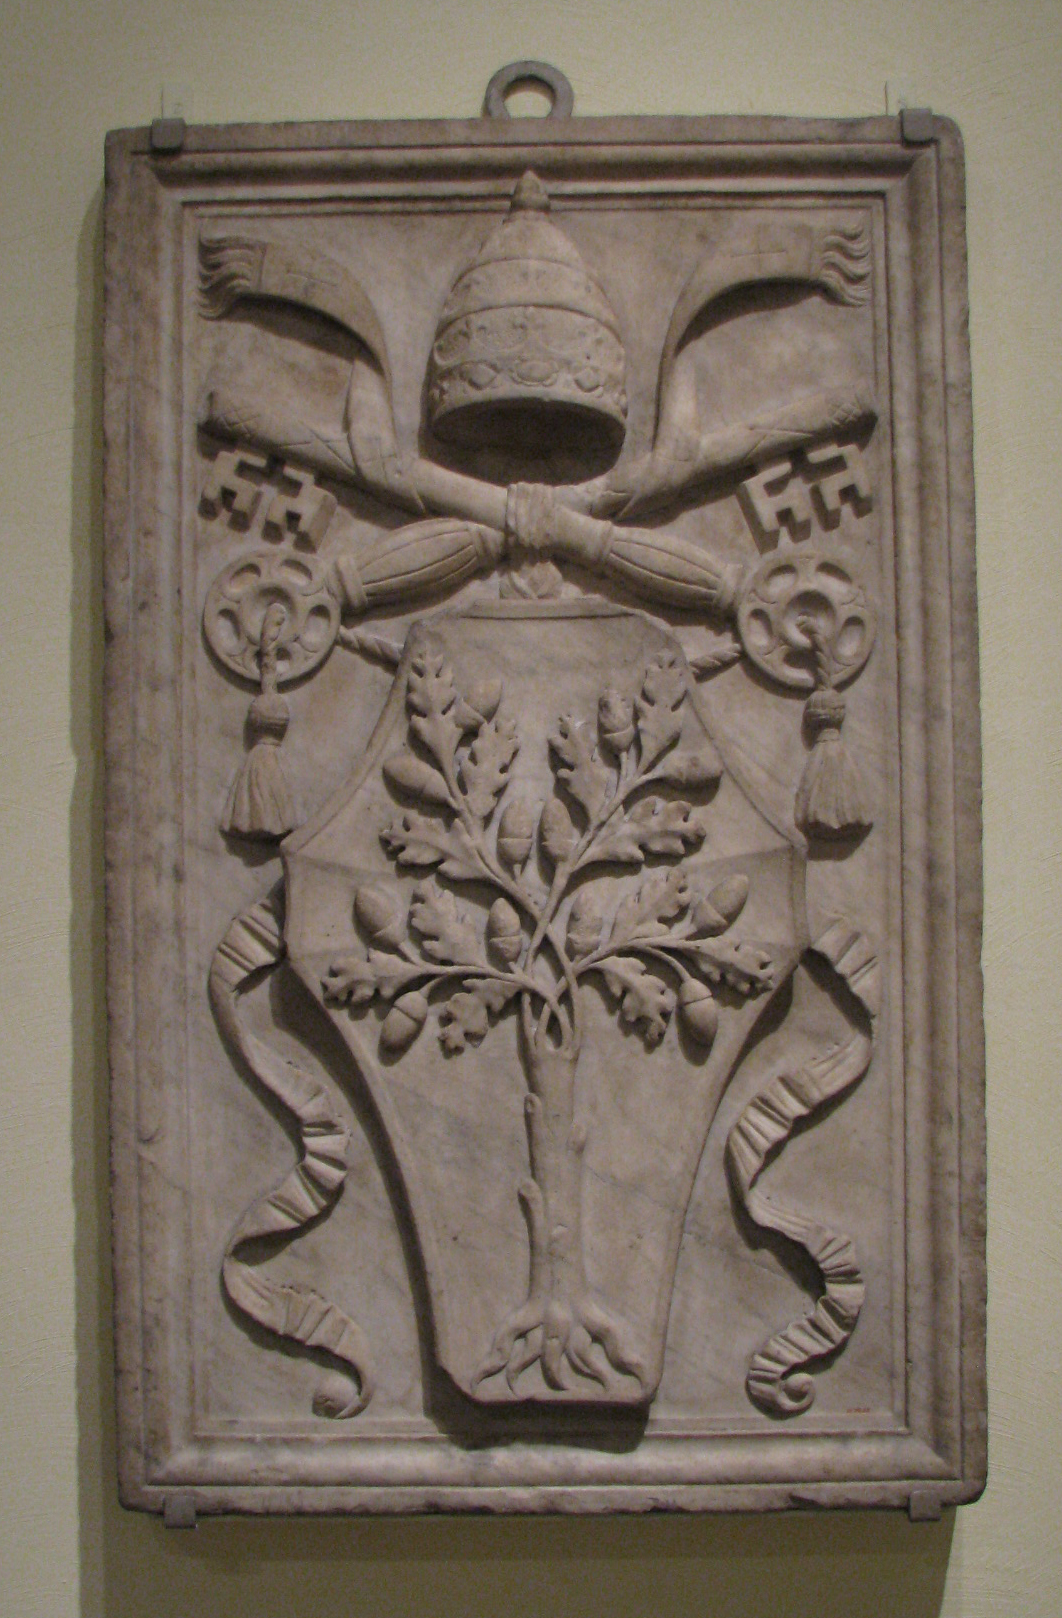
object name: papal arm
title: Arms of Pope Julius II (Giuliano della Rovere, reigned 1503–13)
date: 1501-1533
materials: marble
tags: trees,coat of arms